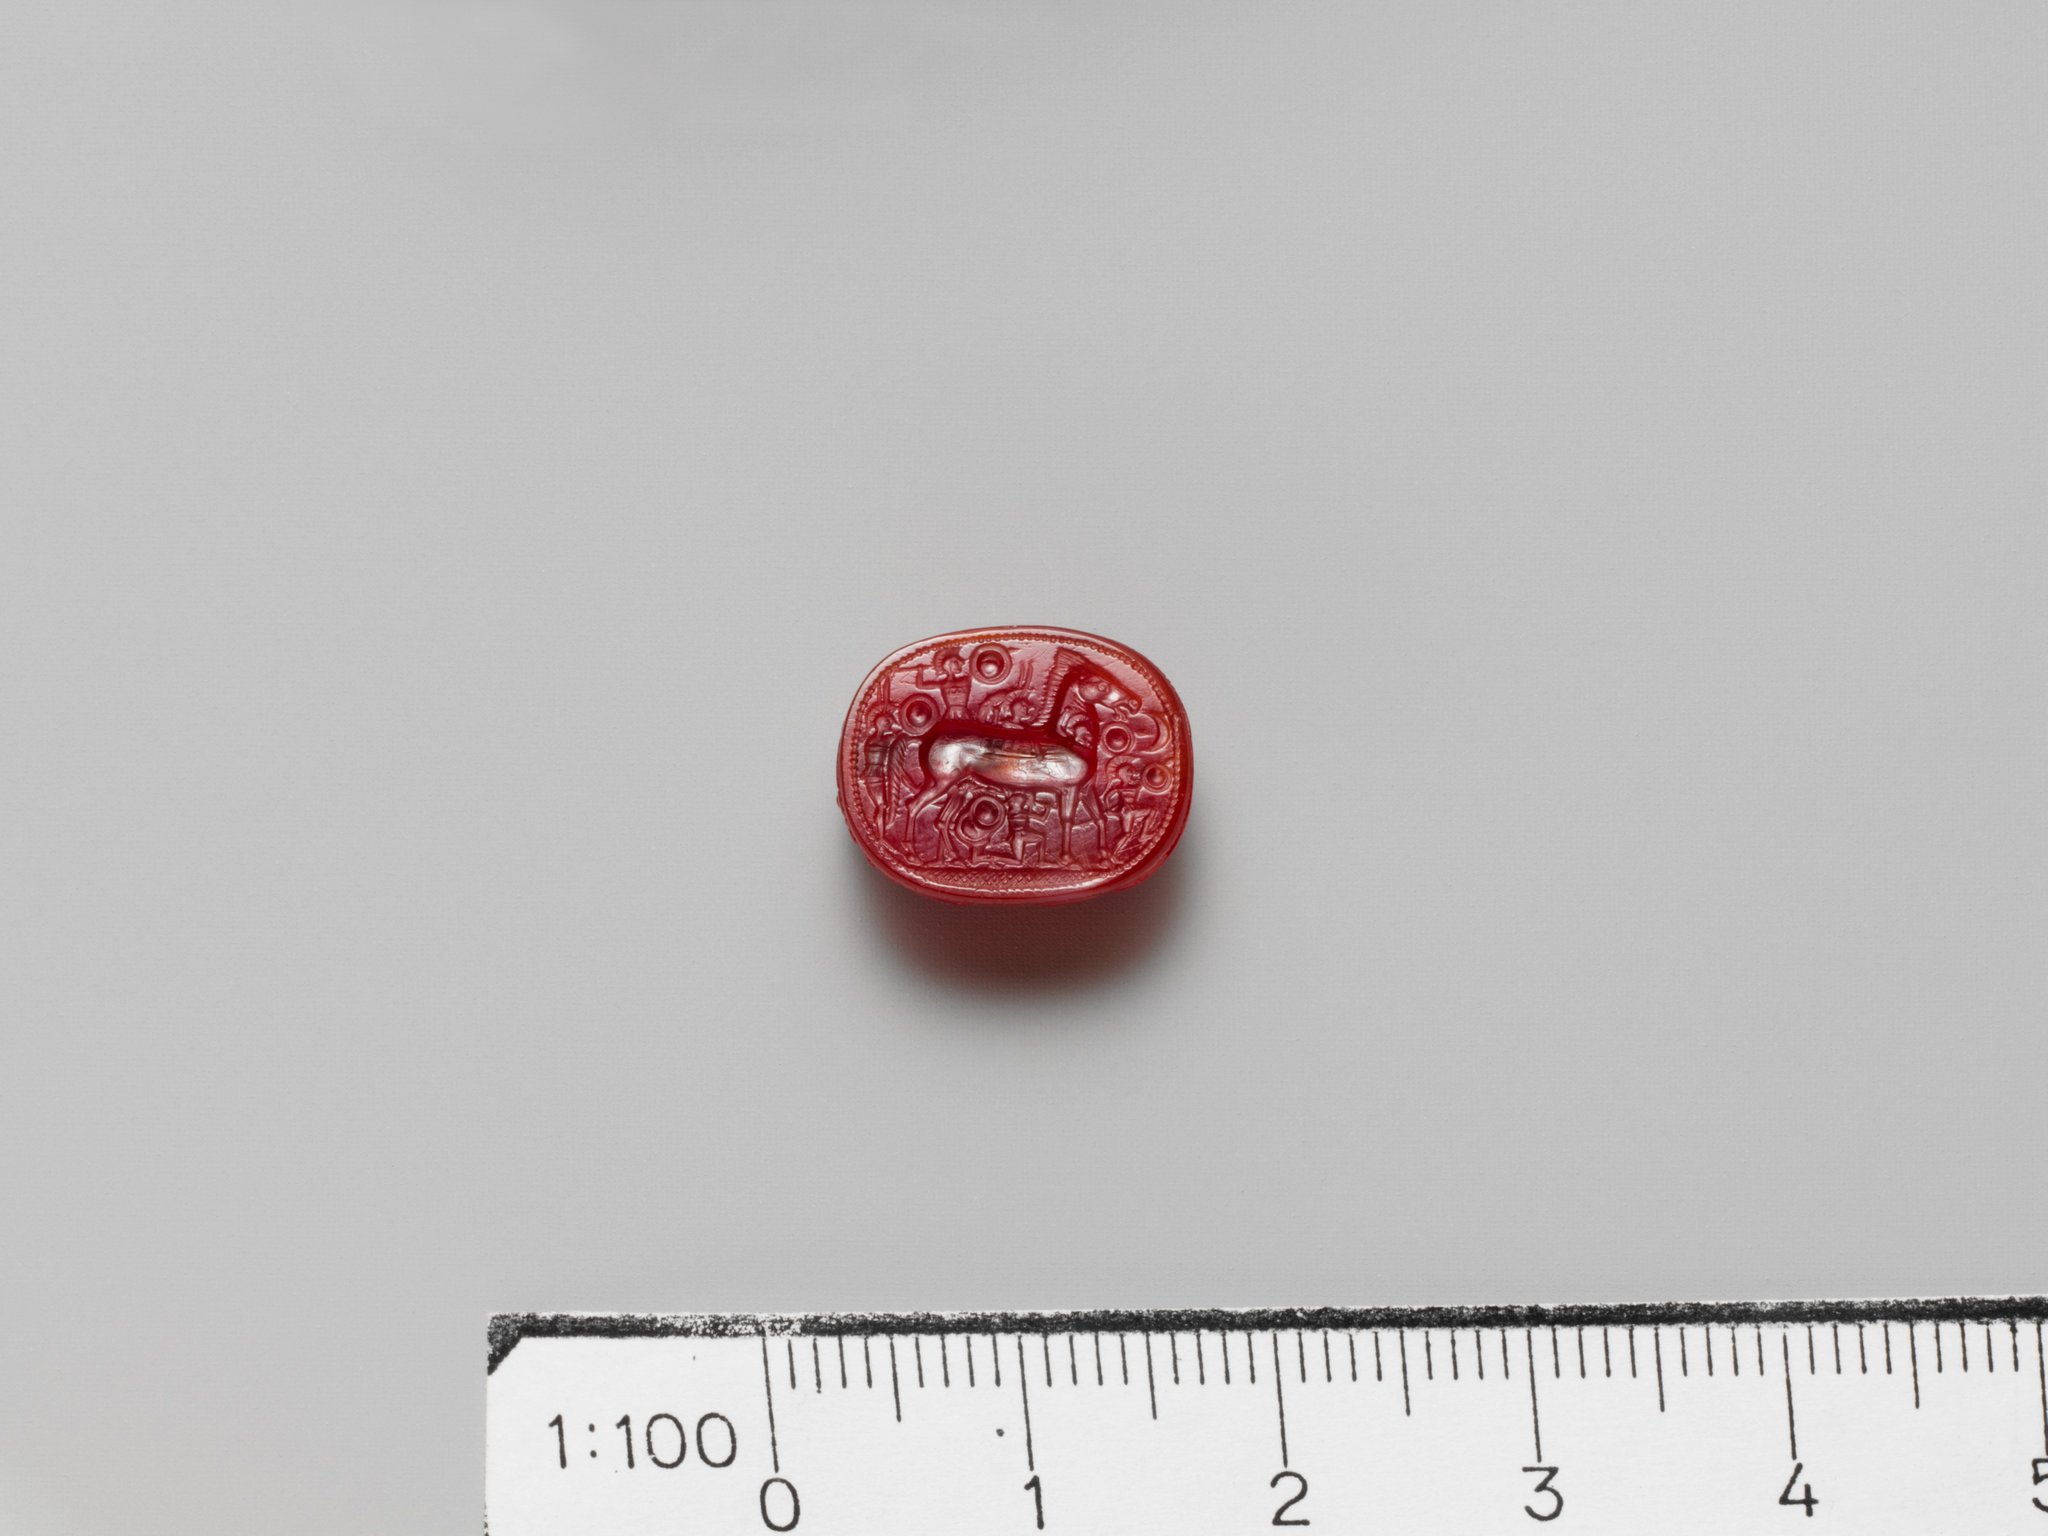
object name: scarab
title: Carnelian scarab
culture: etruscan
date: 500-475 BCE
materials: gemstone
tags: soldiers,shields,spears,horses